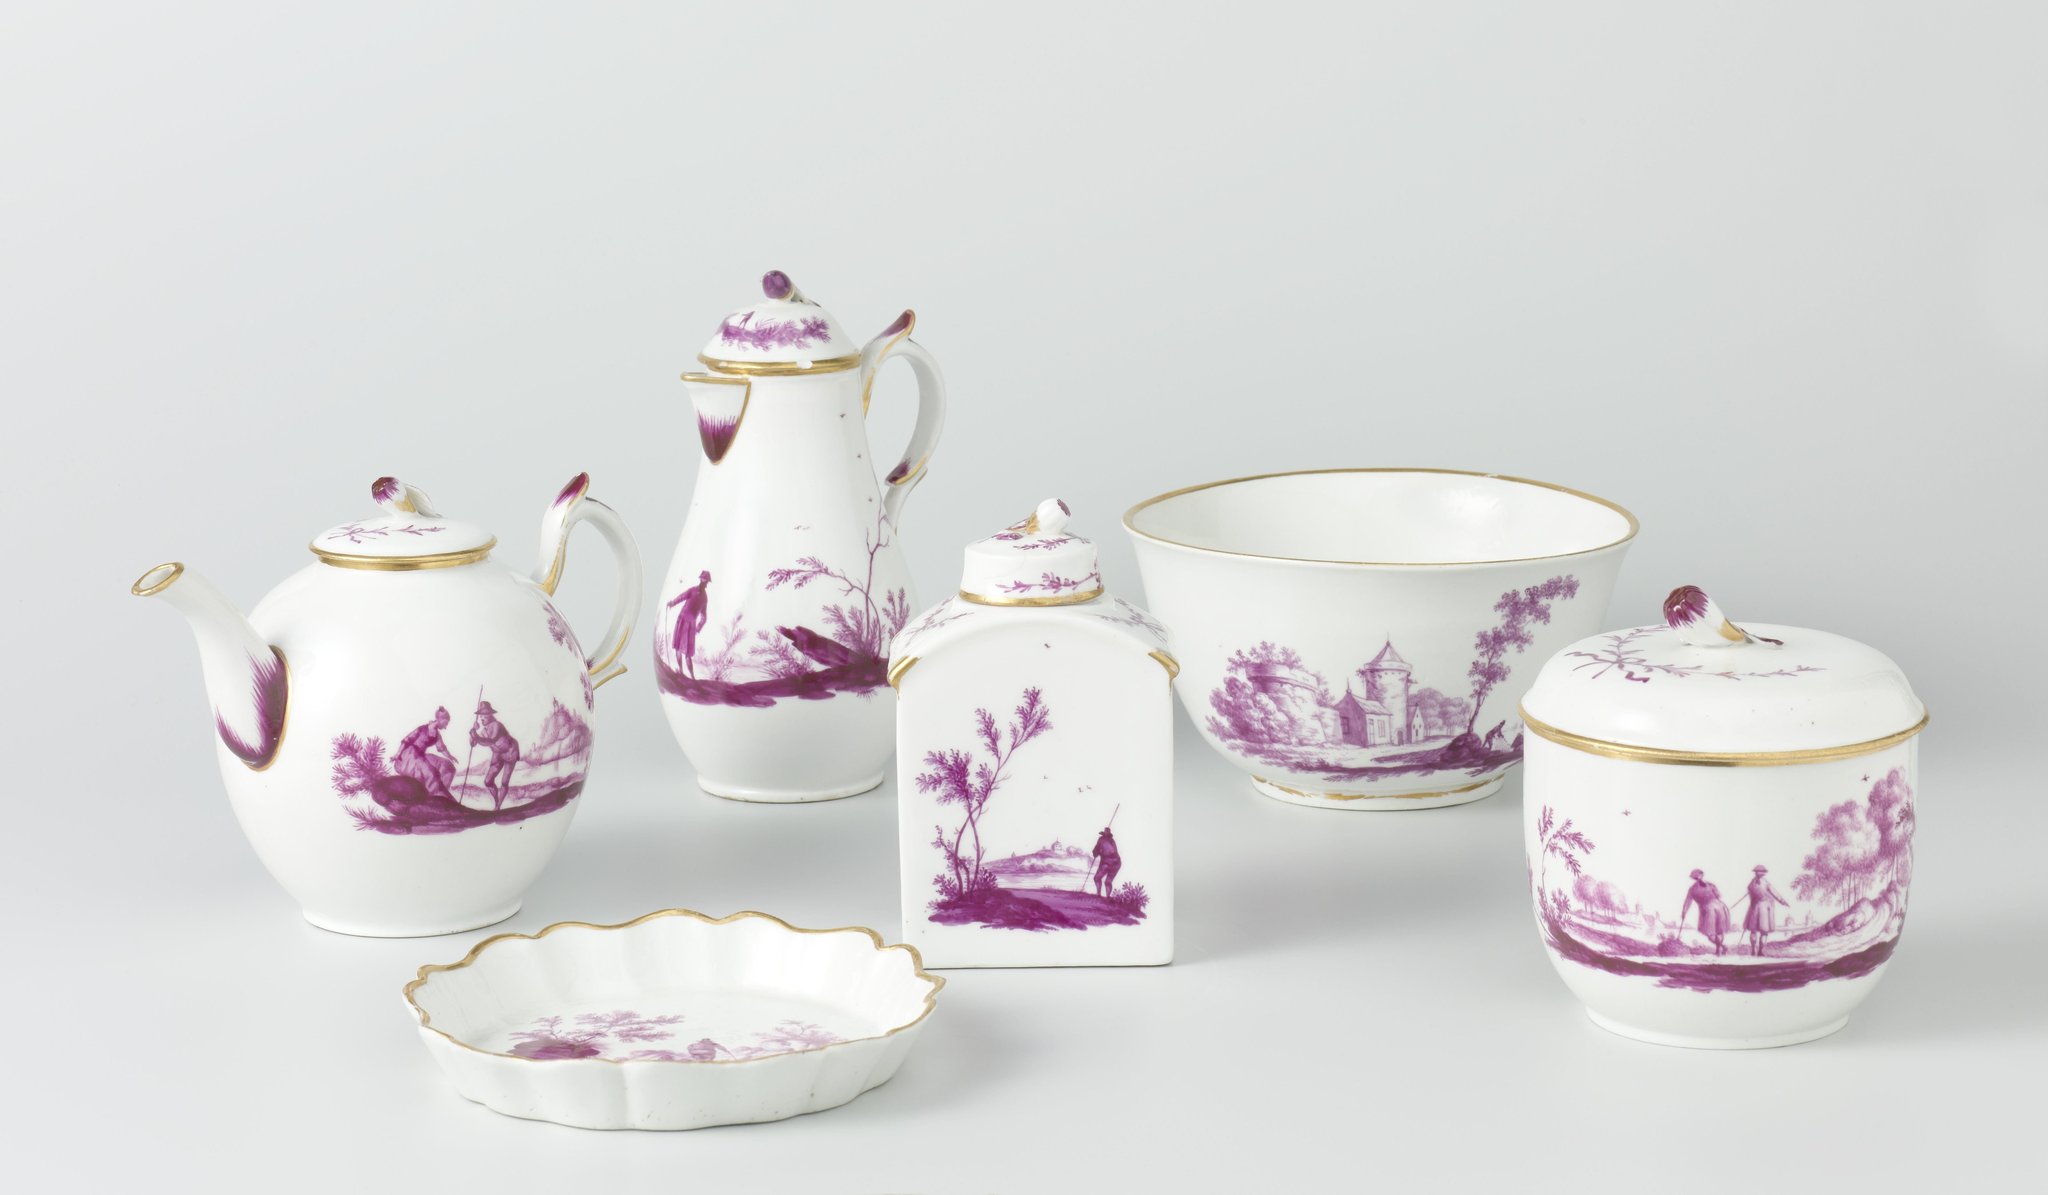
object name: vessel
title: Theeservies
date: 1775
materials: porcelain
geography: loosdrecht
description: Parts of a tea service. Porcelain. Loosdrecht, c. 1774 - 1776. Factory of Joannes de Mol. The tea caddy, which dates from c. 1782, was probably added to an older tea service. Given by the Belport Familien Stiftung, 1977.